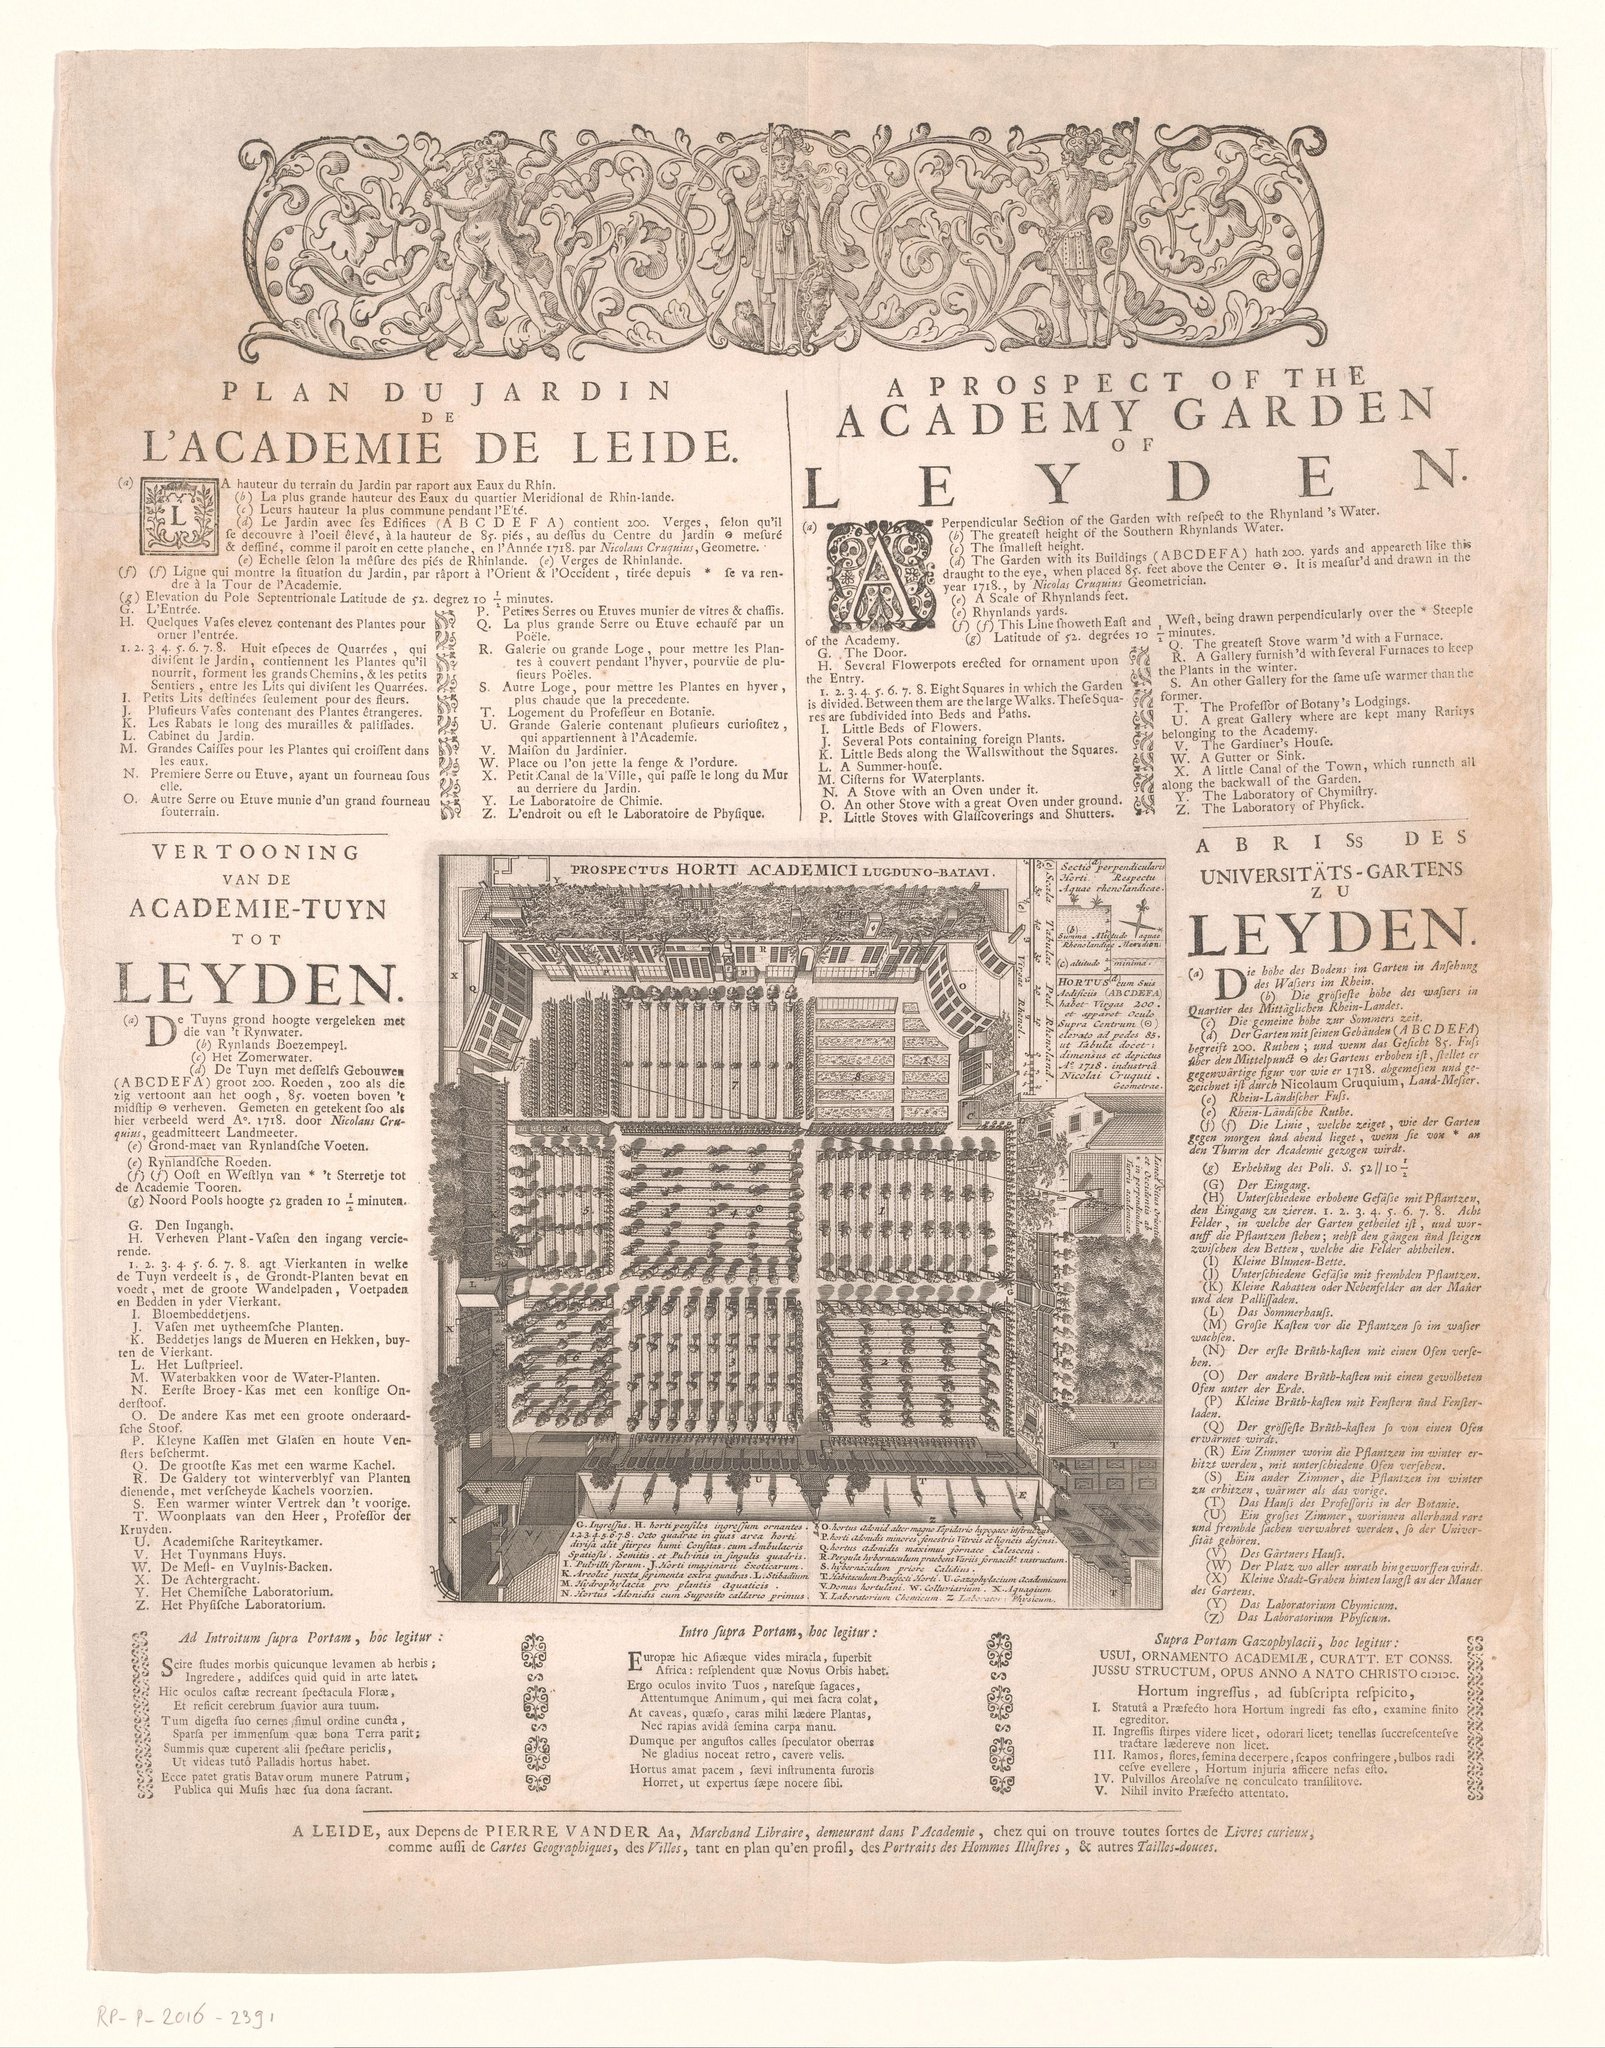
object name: ornament print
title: Hortus Botanicus van de Universiteit Leiden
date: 1718-1733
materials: paper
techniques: engraving, letterpress printing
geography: leiden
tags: botanic garden, 'hortus botanicus', university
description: Gezicht op de Hortus Botanicus van de Universiteit van Leiden naar het ontwerp van Nicolaas Crucquius uit 1718. Rondom een beschrijvende legenda in het Frans, Engels, Nederlands en Duits. Aan de bovenzijde Hercules, Minerva en een soldaat in een ornament van ranken.